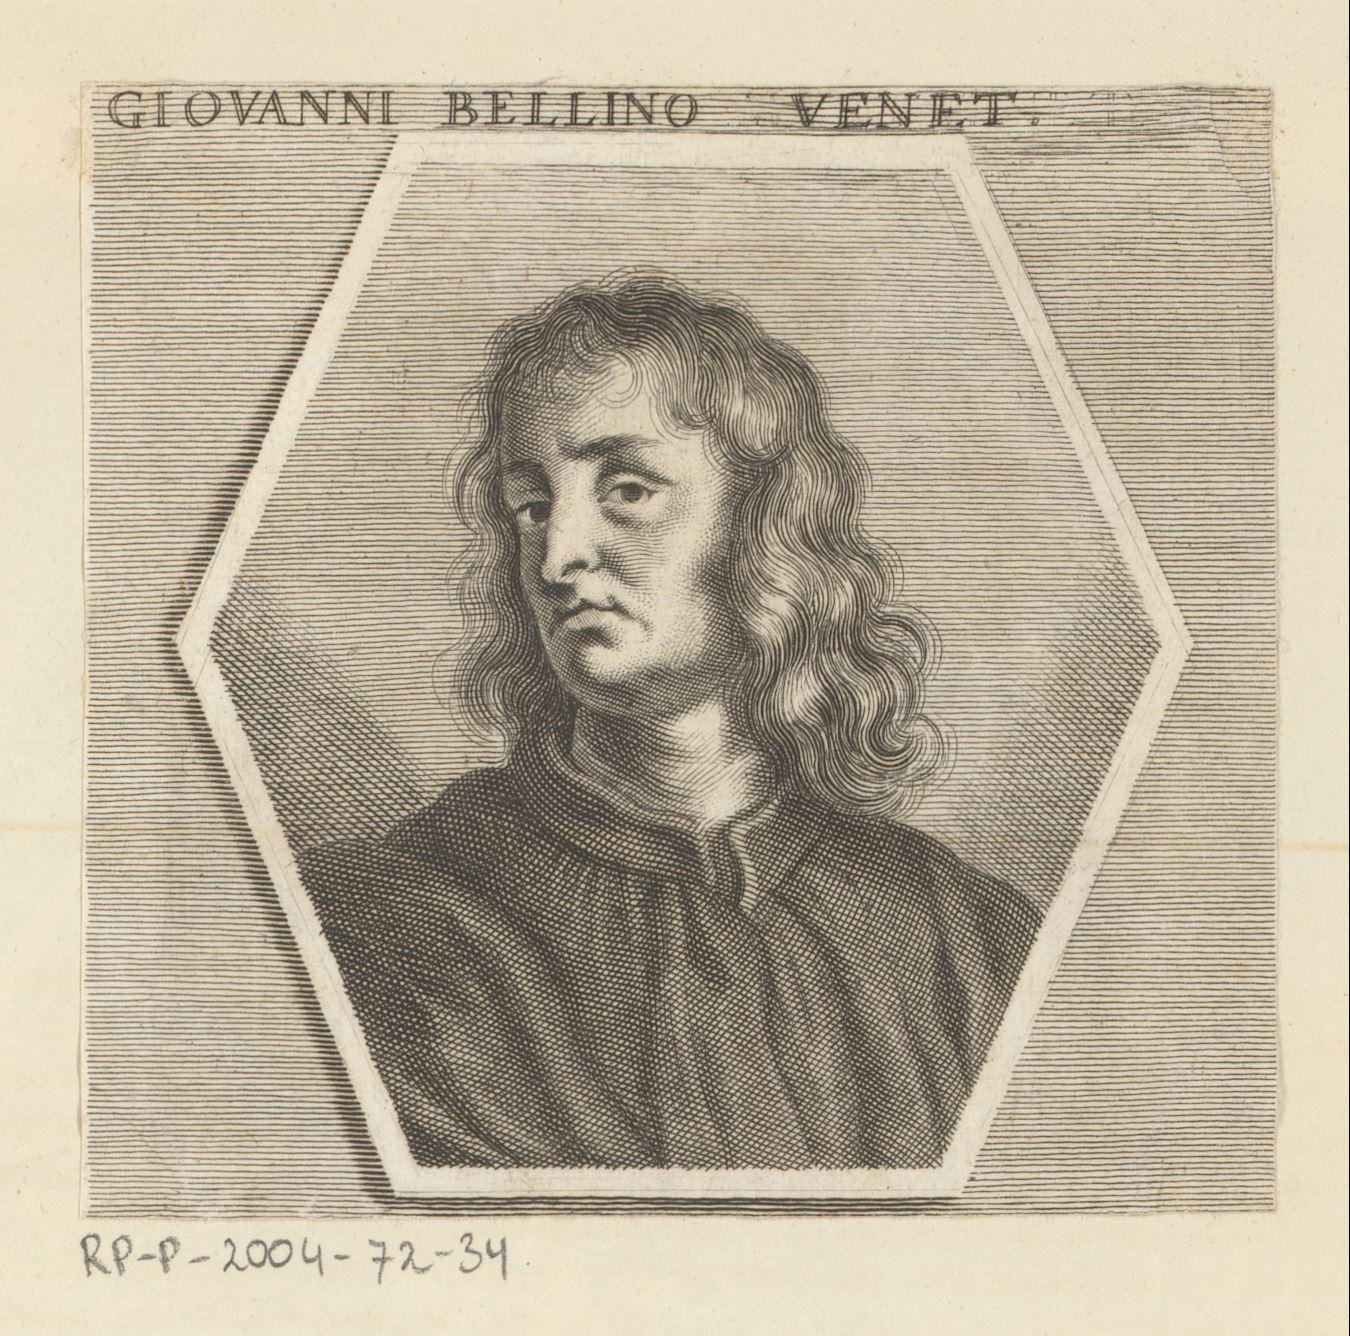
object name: print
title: Giovanni Bellino Venet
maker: philipp kilian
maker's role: print maker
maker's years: 1628-1693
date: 1768-1775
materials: paper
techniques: engraving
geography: nuremberg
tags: venice, draughtsman, giovanni bellini, historical persons, portrait, self-portrait of painter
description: Prent uit: Sandrart, Joachim von. Teutsche Academie der Bau- Bildhauer- und Maler-Kunst: worinn die Regeln und Lehrsätze dieser Künste gegeben. 14 dln. Neurenberg: erven Johann Andreas Endter, [1774], dl. 7, p. L. De samensteller heeft deze prent in het album geplakt als illustratie bij: Pilkington, Matthew en Johann Heinrich Füssli. A dictionary of painters, from the revival of the art to the present period. 4 dln. Londen: John Crowder, 1805, dl. 1, p. 40.